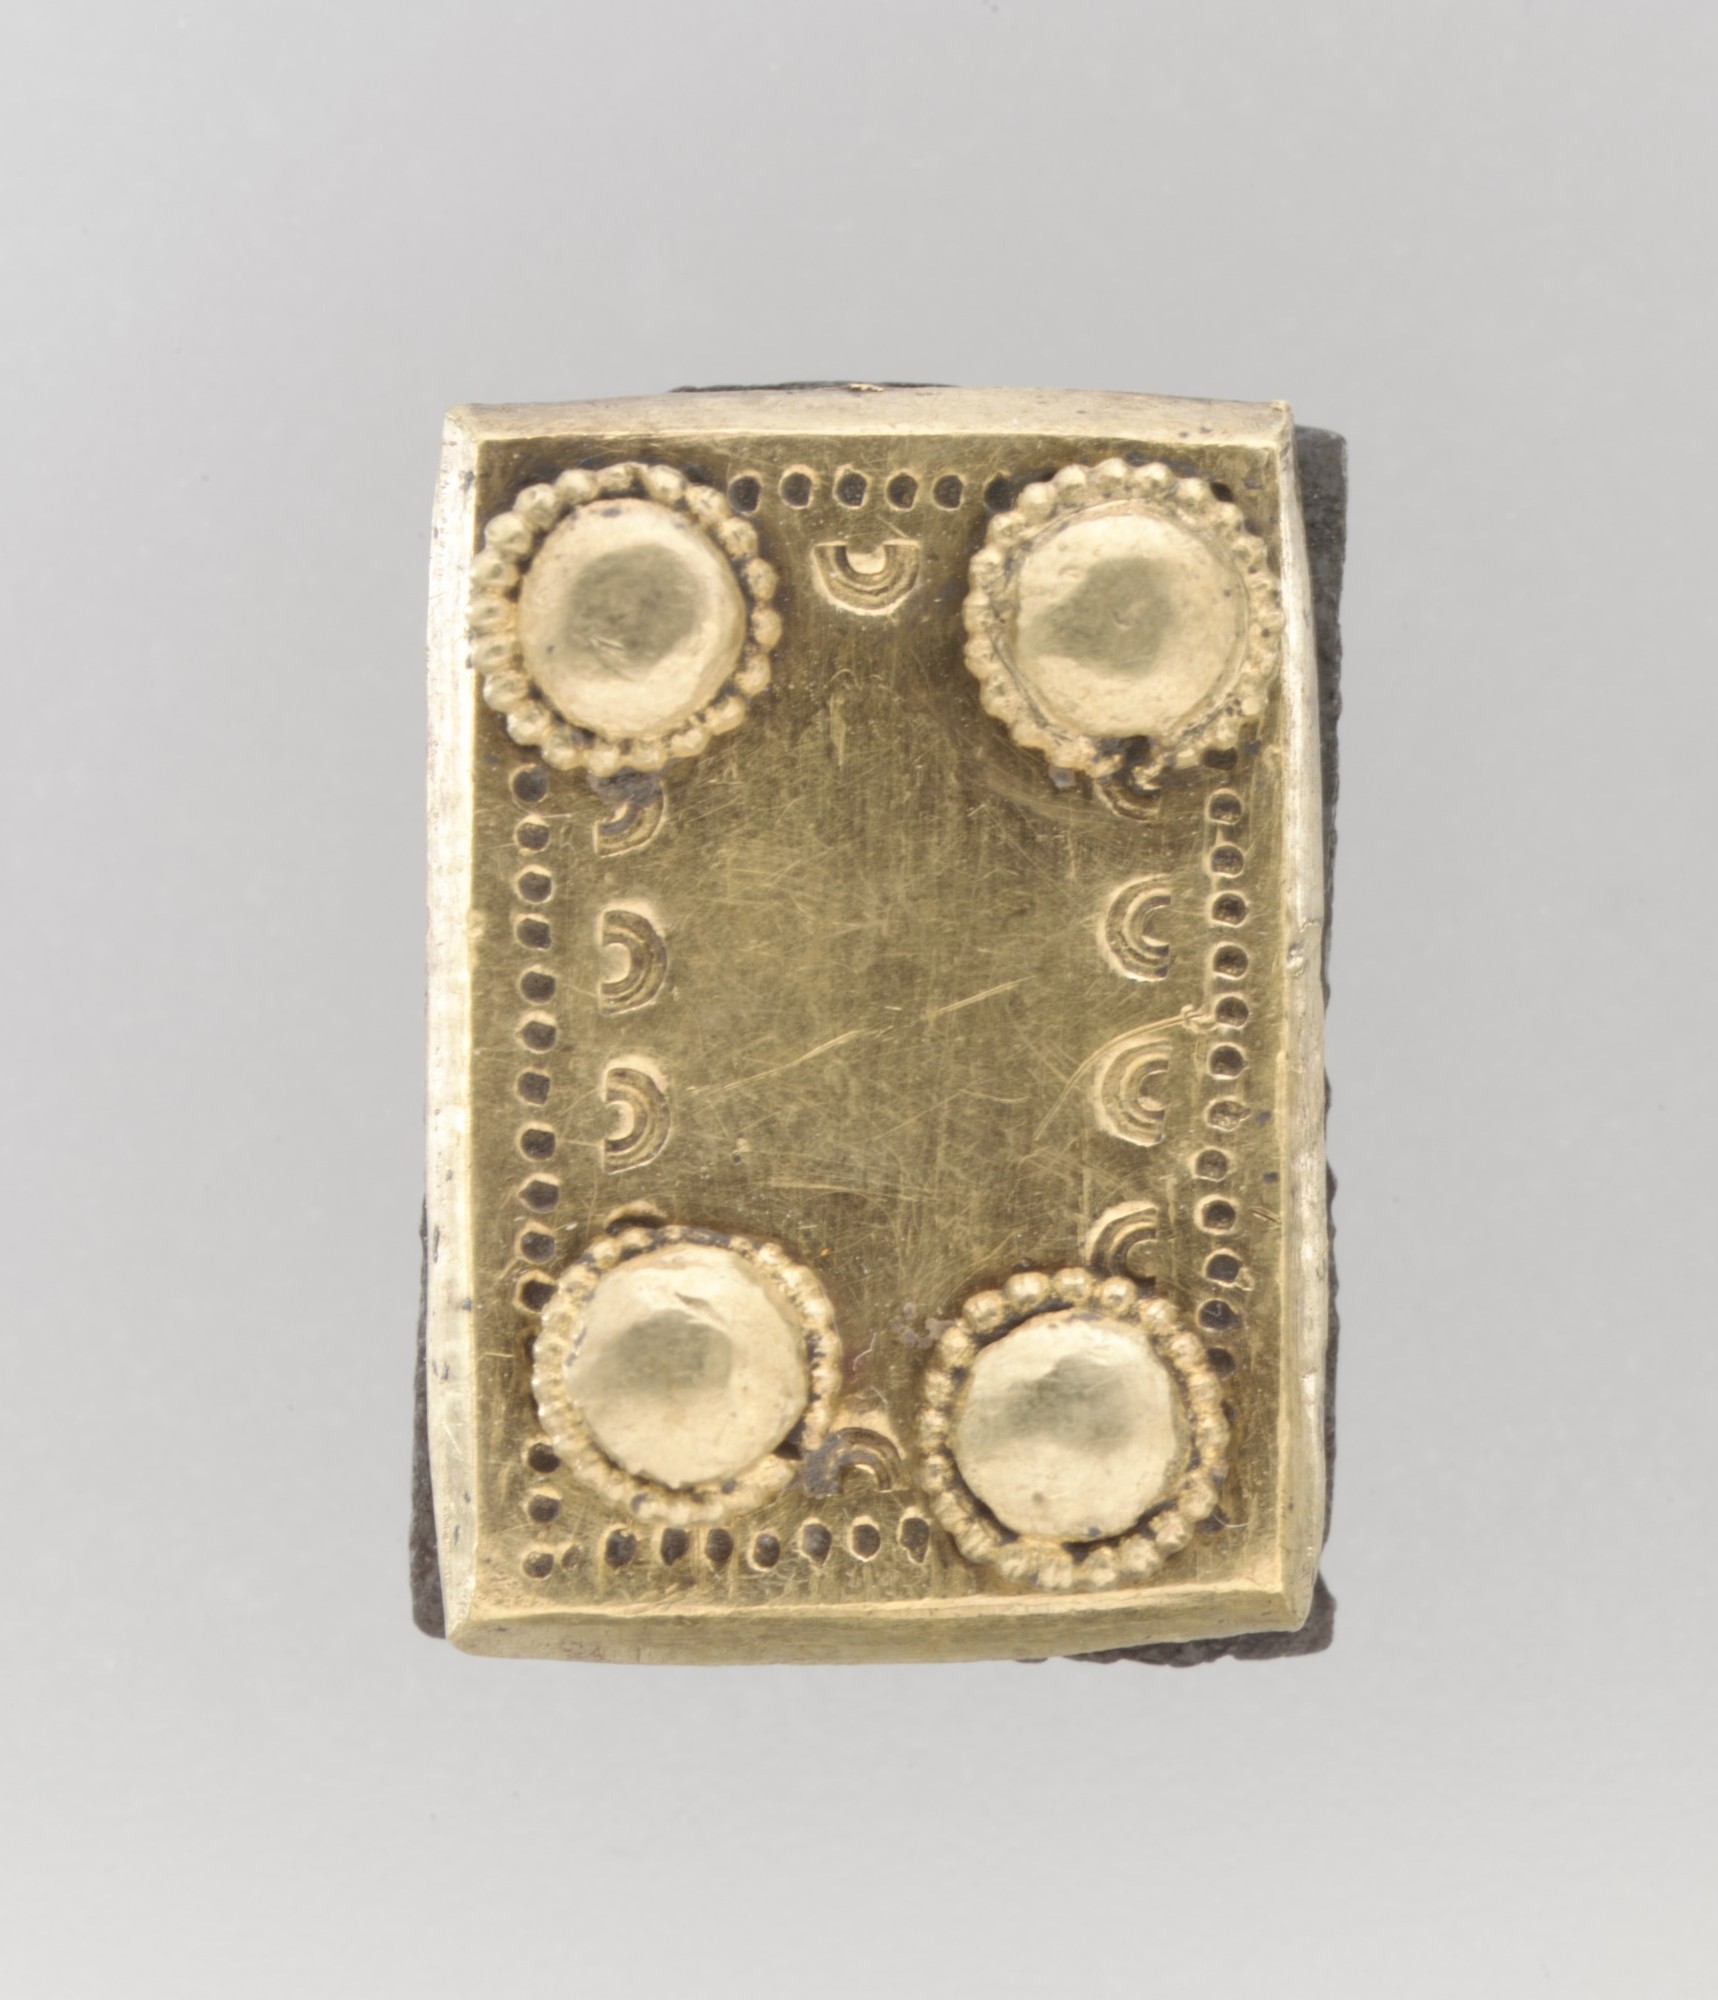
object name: belt plate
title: Gold Back Plate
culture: langobardic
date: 600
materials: gold, silver